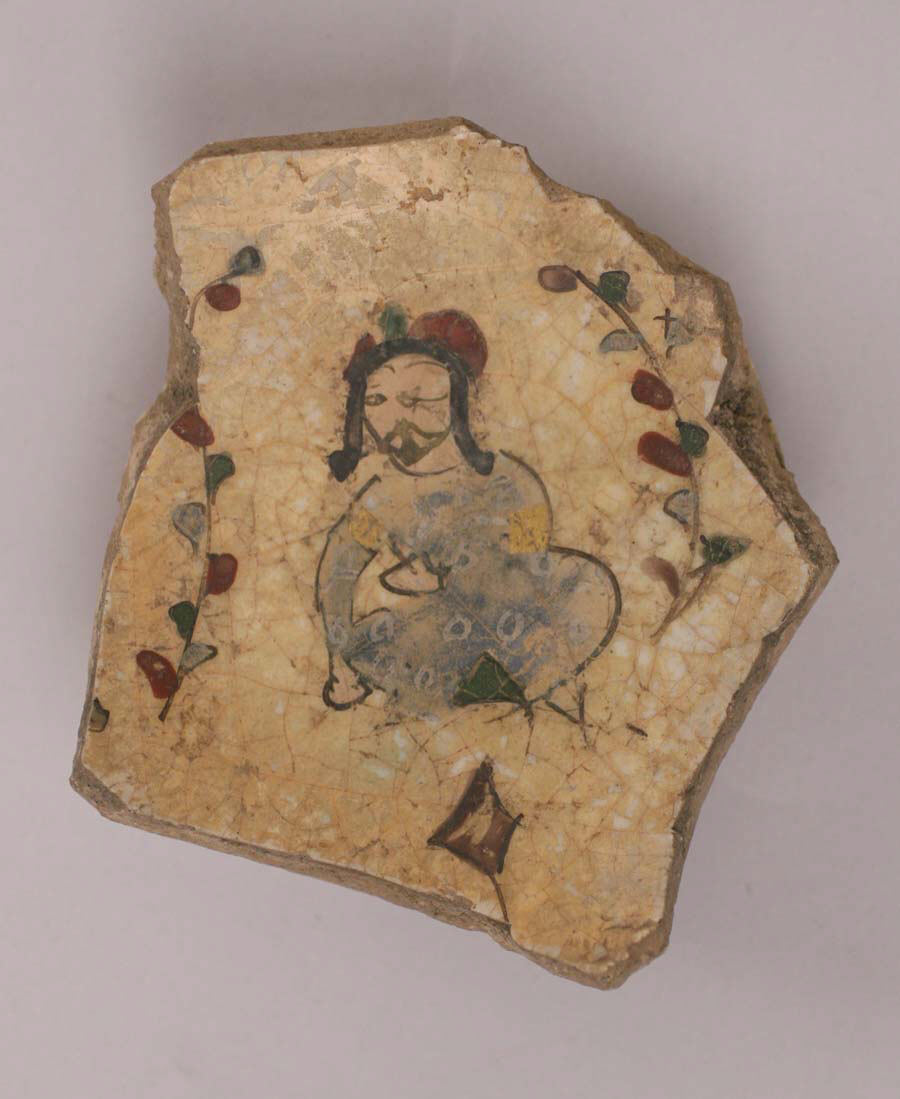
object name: fragment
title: Fragment of a Bowl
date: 1101-1300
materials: stonepaste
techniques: overglaze, painting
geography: iran